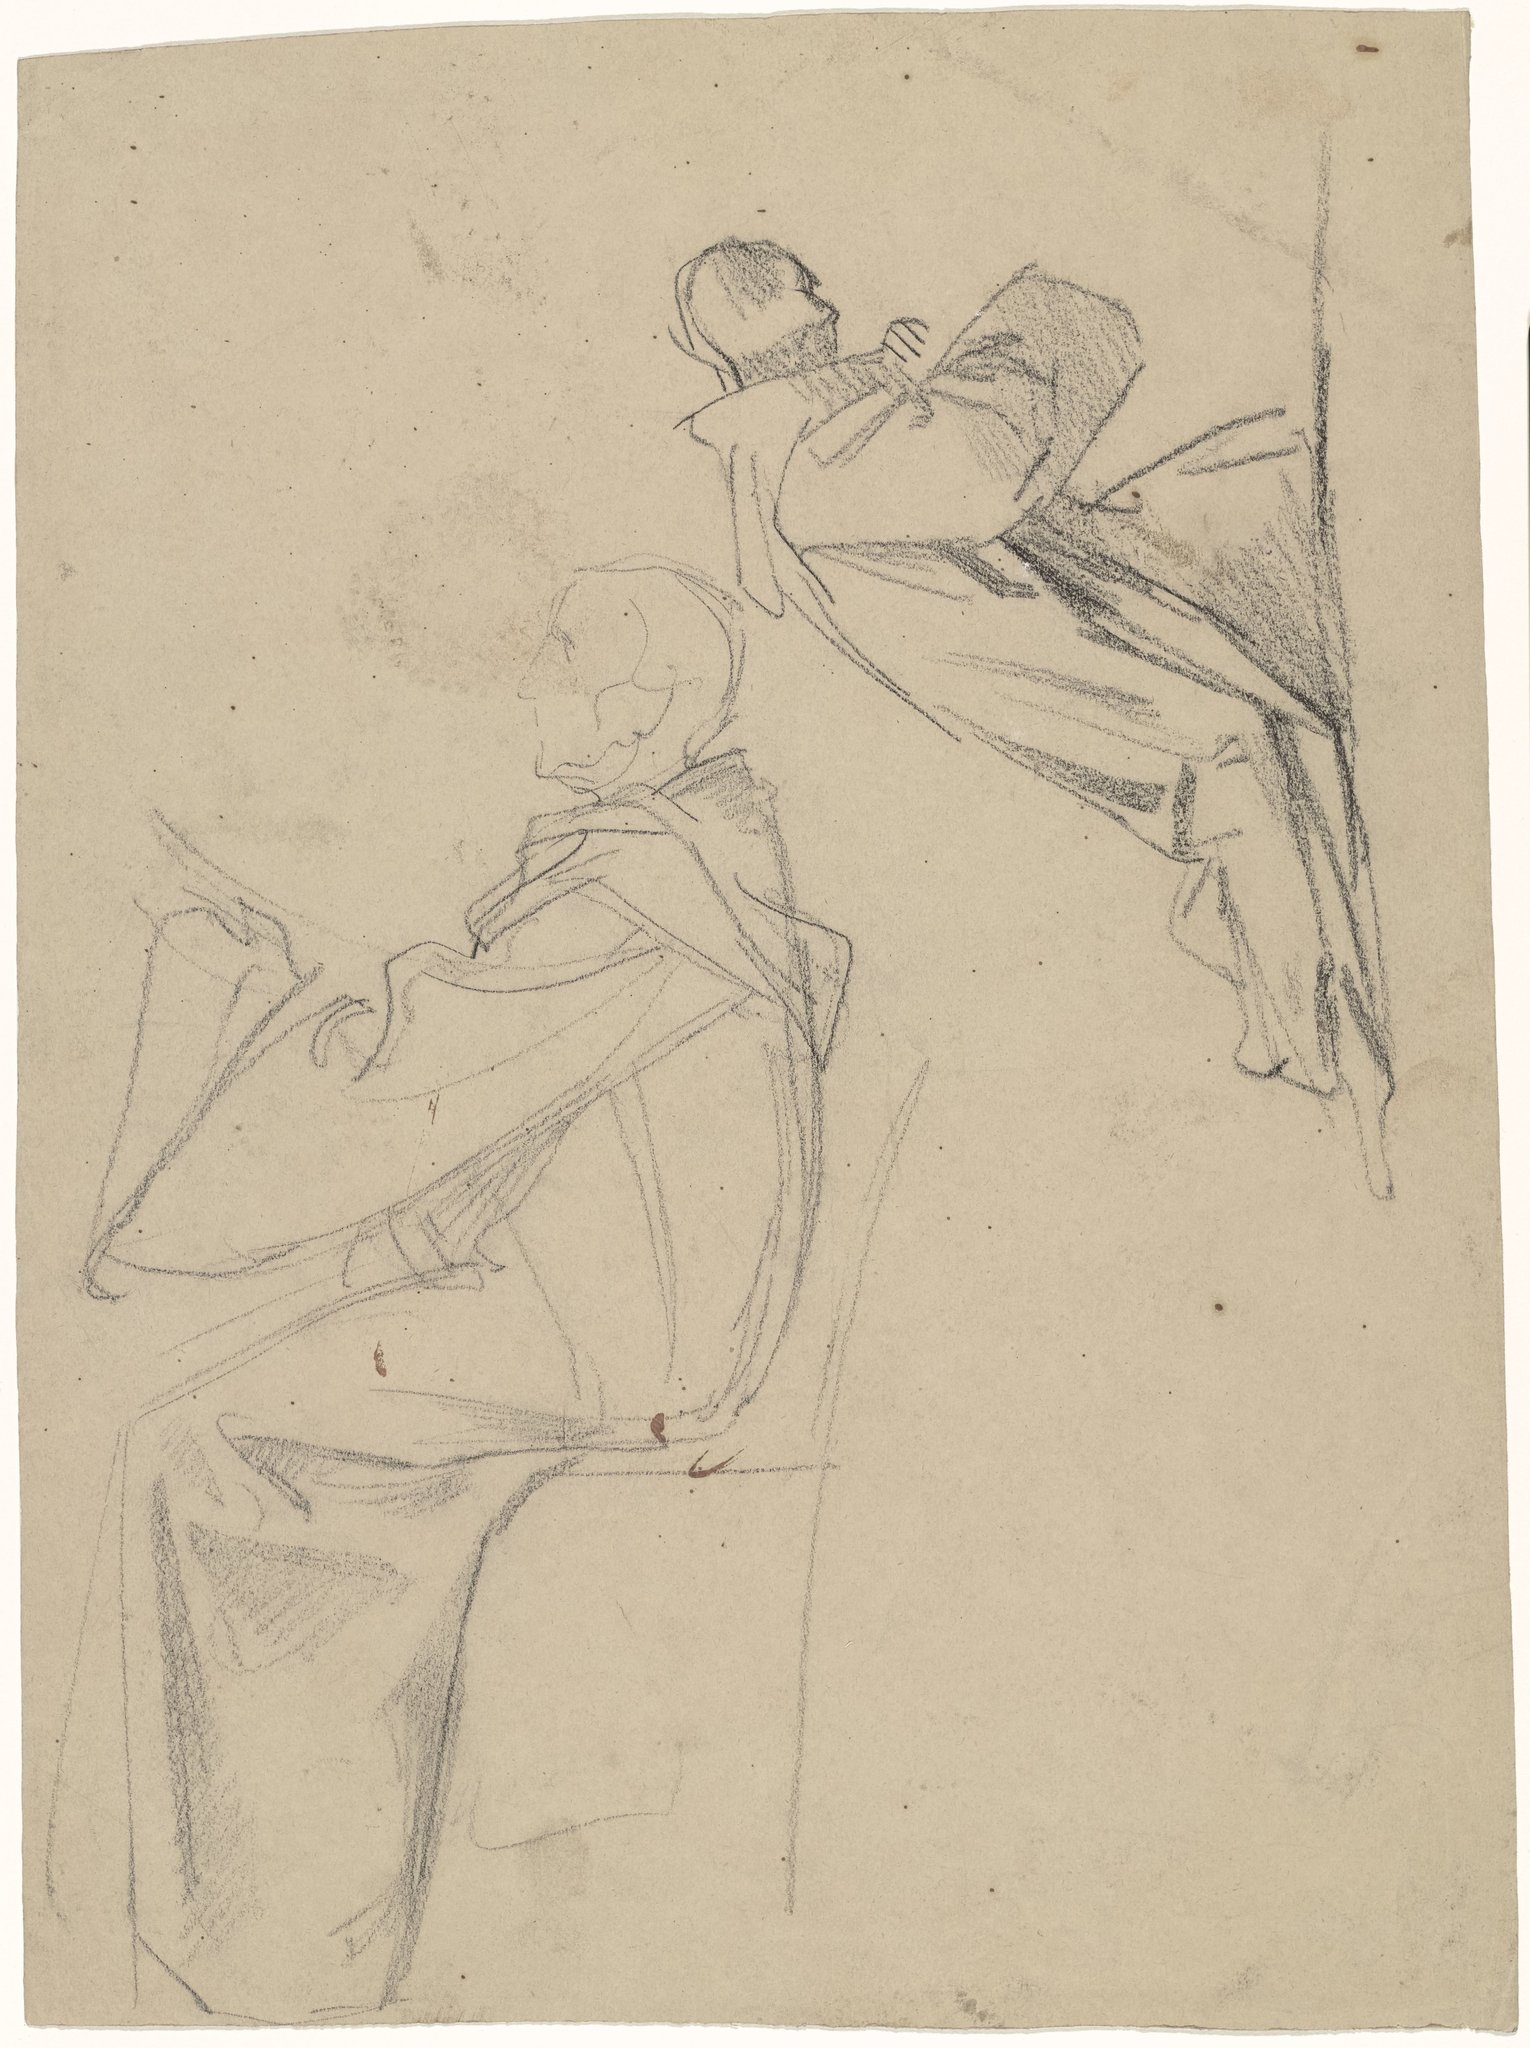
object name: drawing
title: Studies van een zittende en een knielende monnik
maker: antoon derkinderen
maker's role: draughtsman, painter, print maker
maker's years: 1859-1925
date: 1869-1925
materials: chalk, paper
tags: monk(s), friar(s)